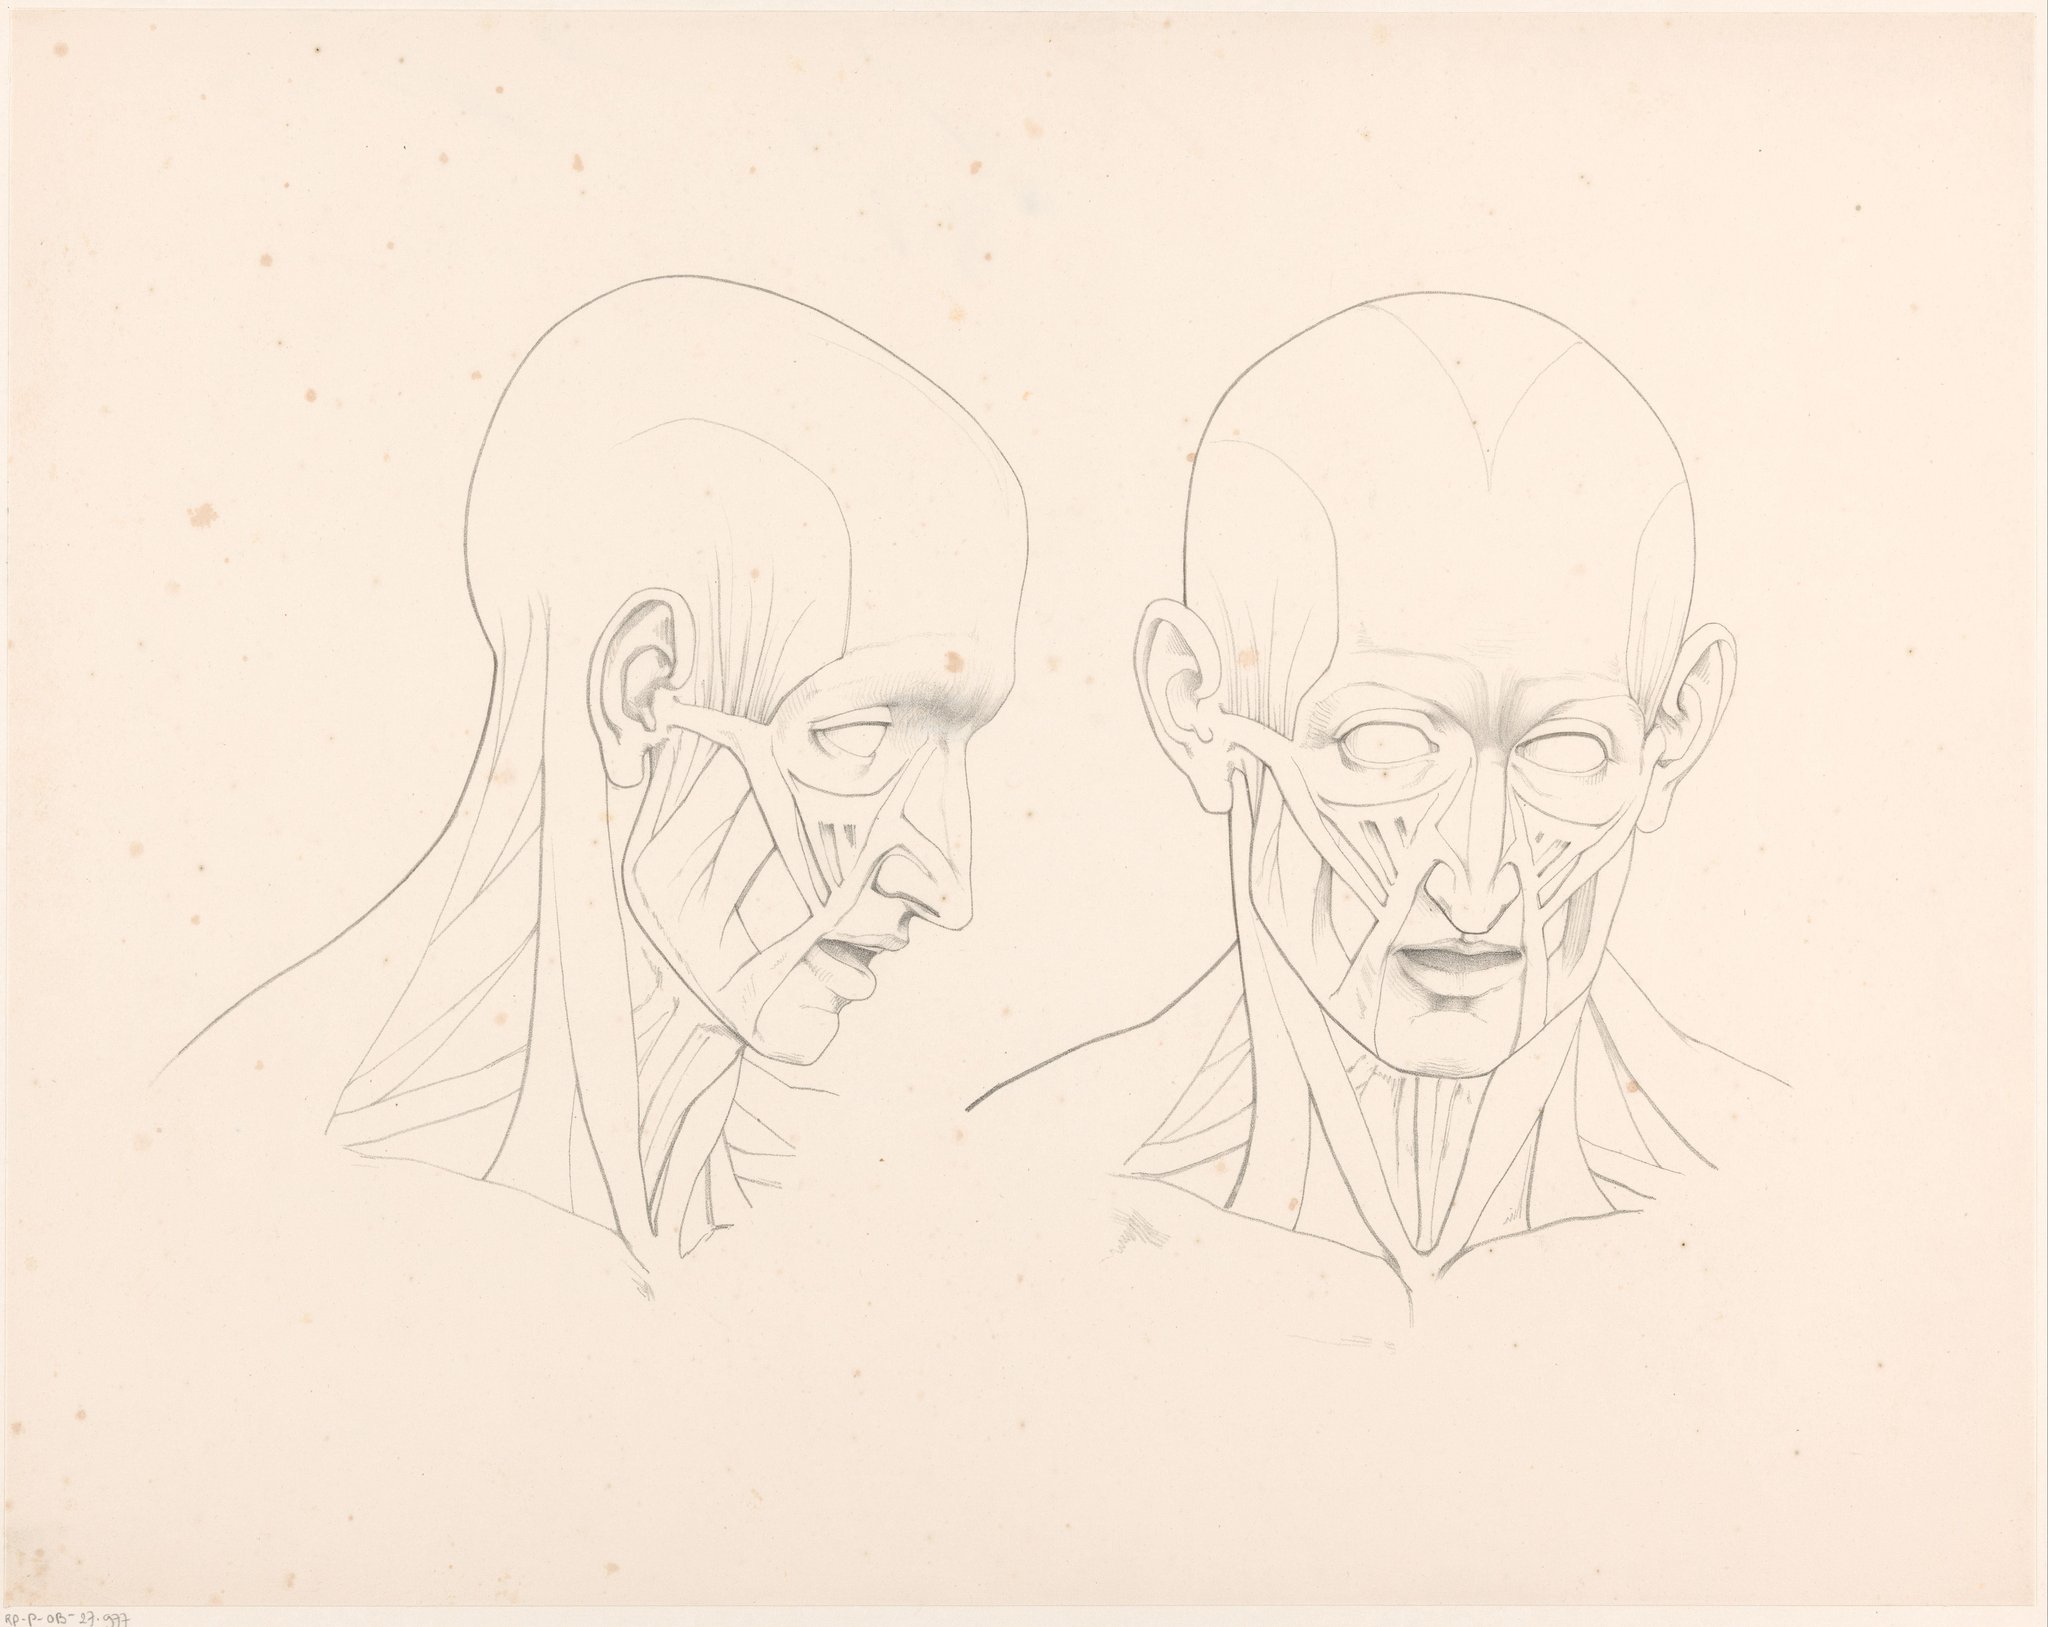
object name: print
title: Tekenvoorbeeld met twee hoofden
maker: jean augustin daiwaille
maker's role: draughtsman, print maker, printer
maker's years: 1786-1850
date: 1820-1833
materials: paper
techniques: lithograph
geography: amsterdam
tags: head (human), mouth slightly open, muscles, anatomical model of the muscles, muscle-man, 'écorché'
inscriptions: collector's mark: Lugt 2228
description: De hoofden bestaan uit spierbundels. Beiden hebben hun mond open.